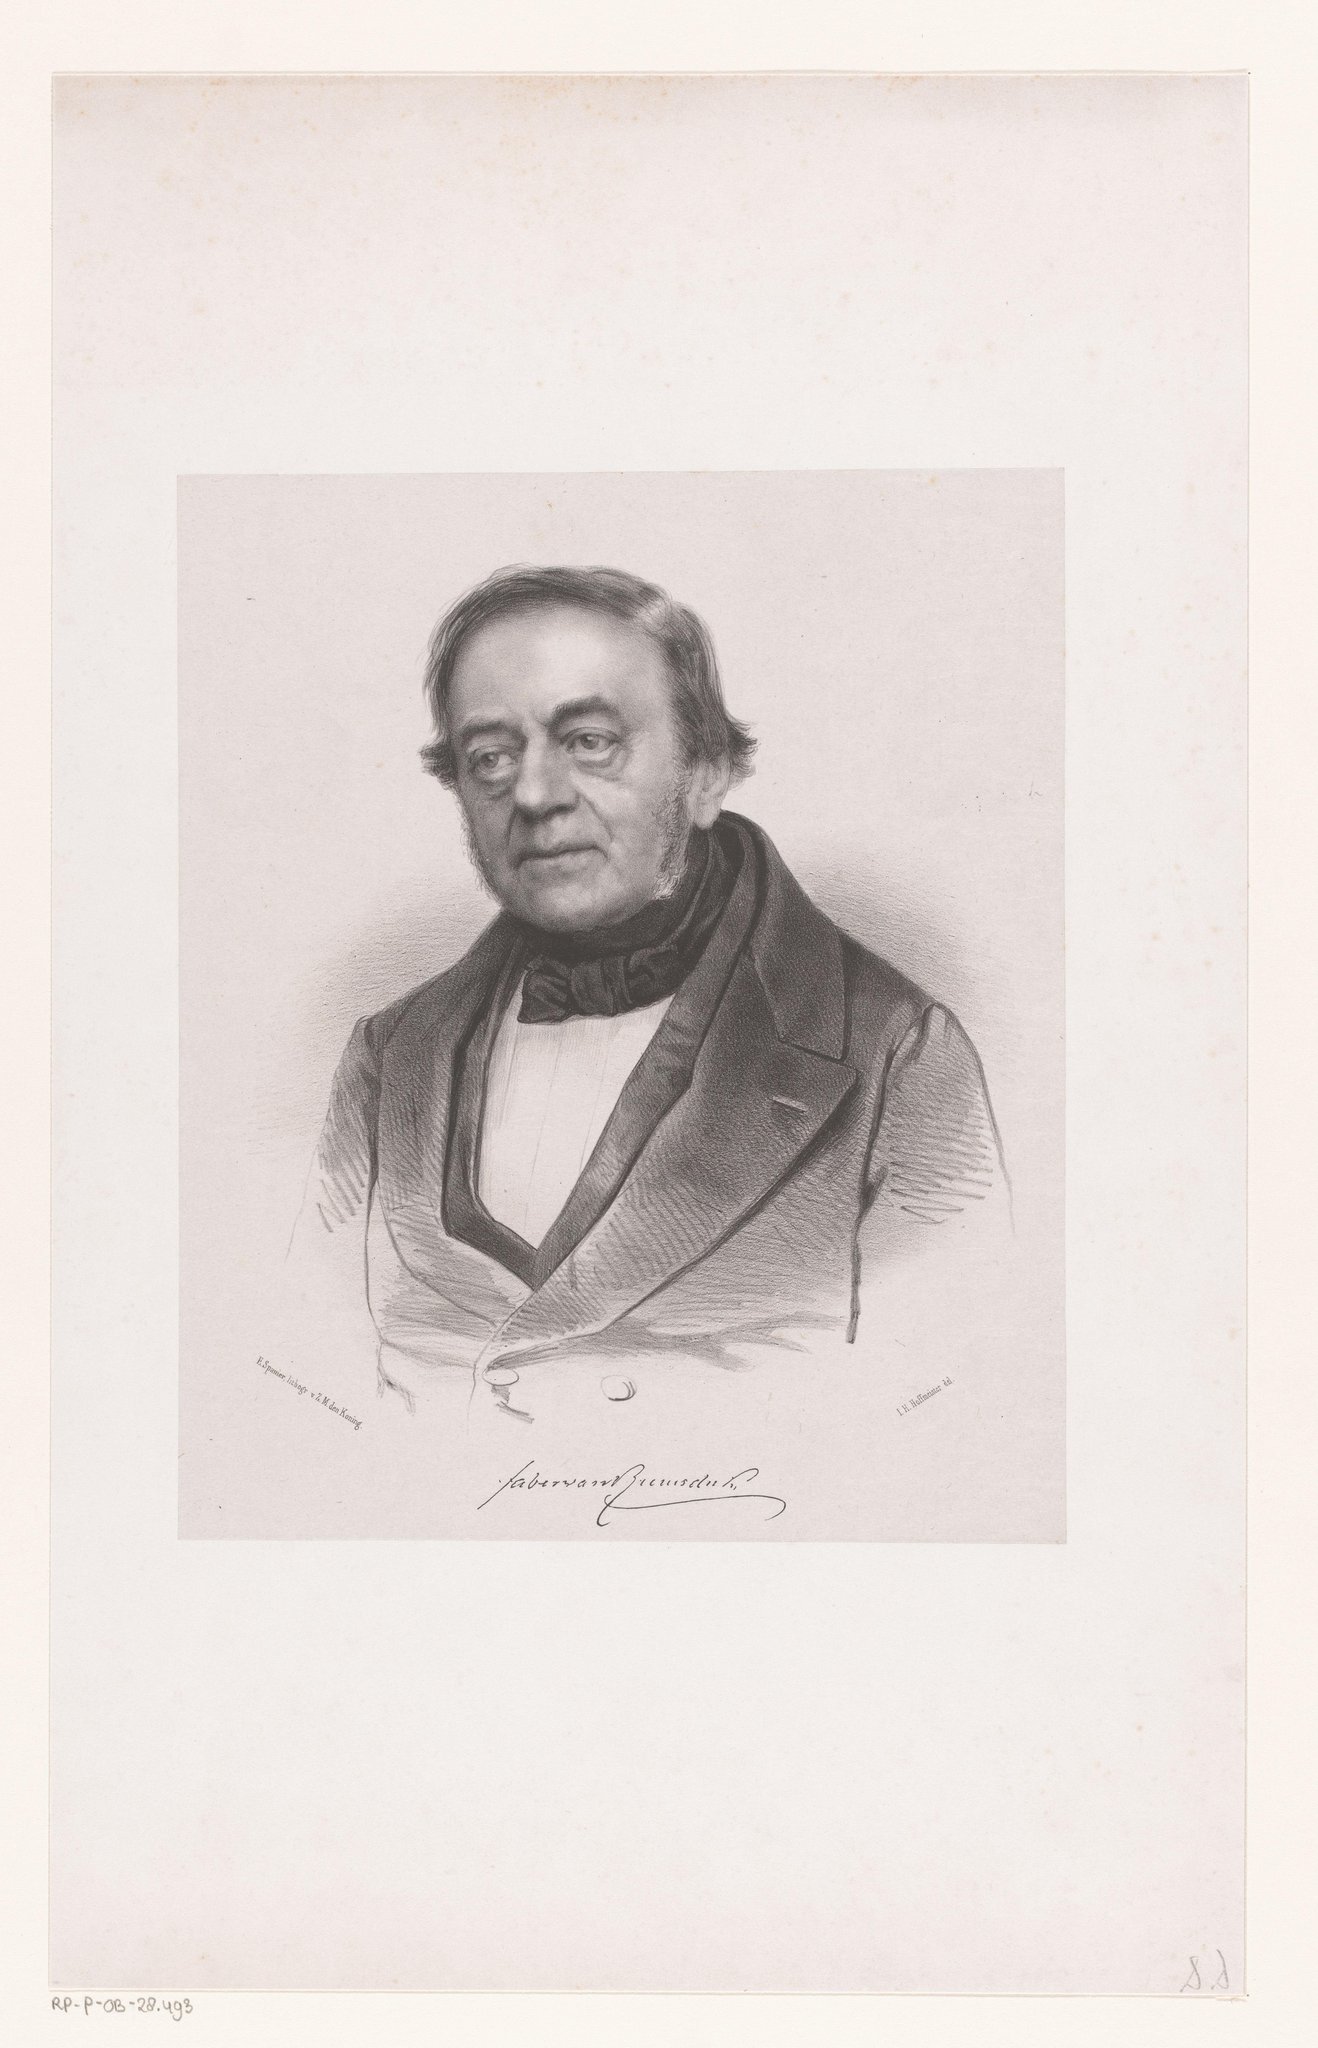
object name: print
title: Portret van Jeremias Cornelis Faber van Riemsdijk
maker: johan hendrik hoffmeister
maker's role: print maker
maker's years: 1823-1904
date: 1851-1863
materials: paper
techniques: lithograph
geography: the hague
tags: haarlem, the hague, historical persons (+ (full) bust portrait)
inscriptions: collector's mark: Lugt 2228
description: Onder het portret de signatuur van de geportretteerde.